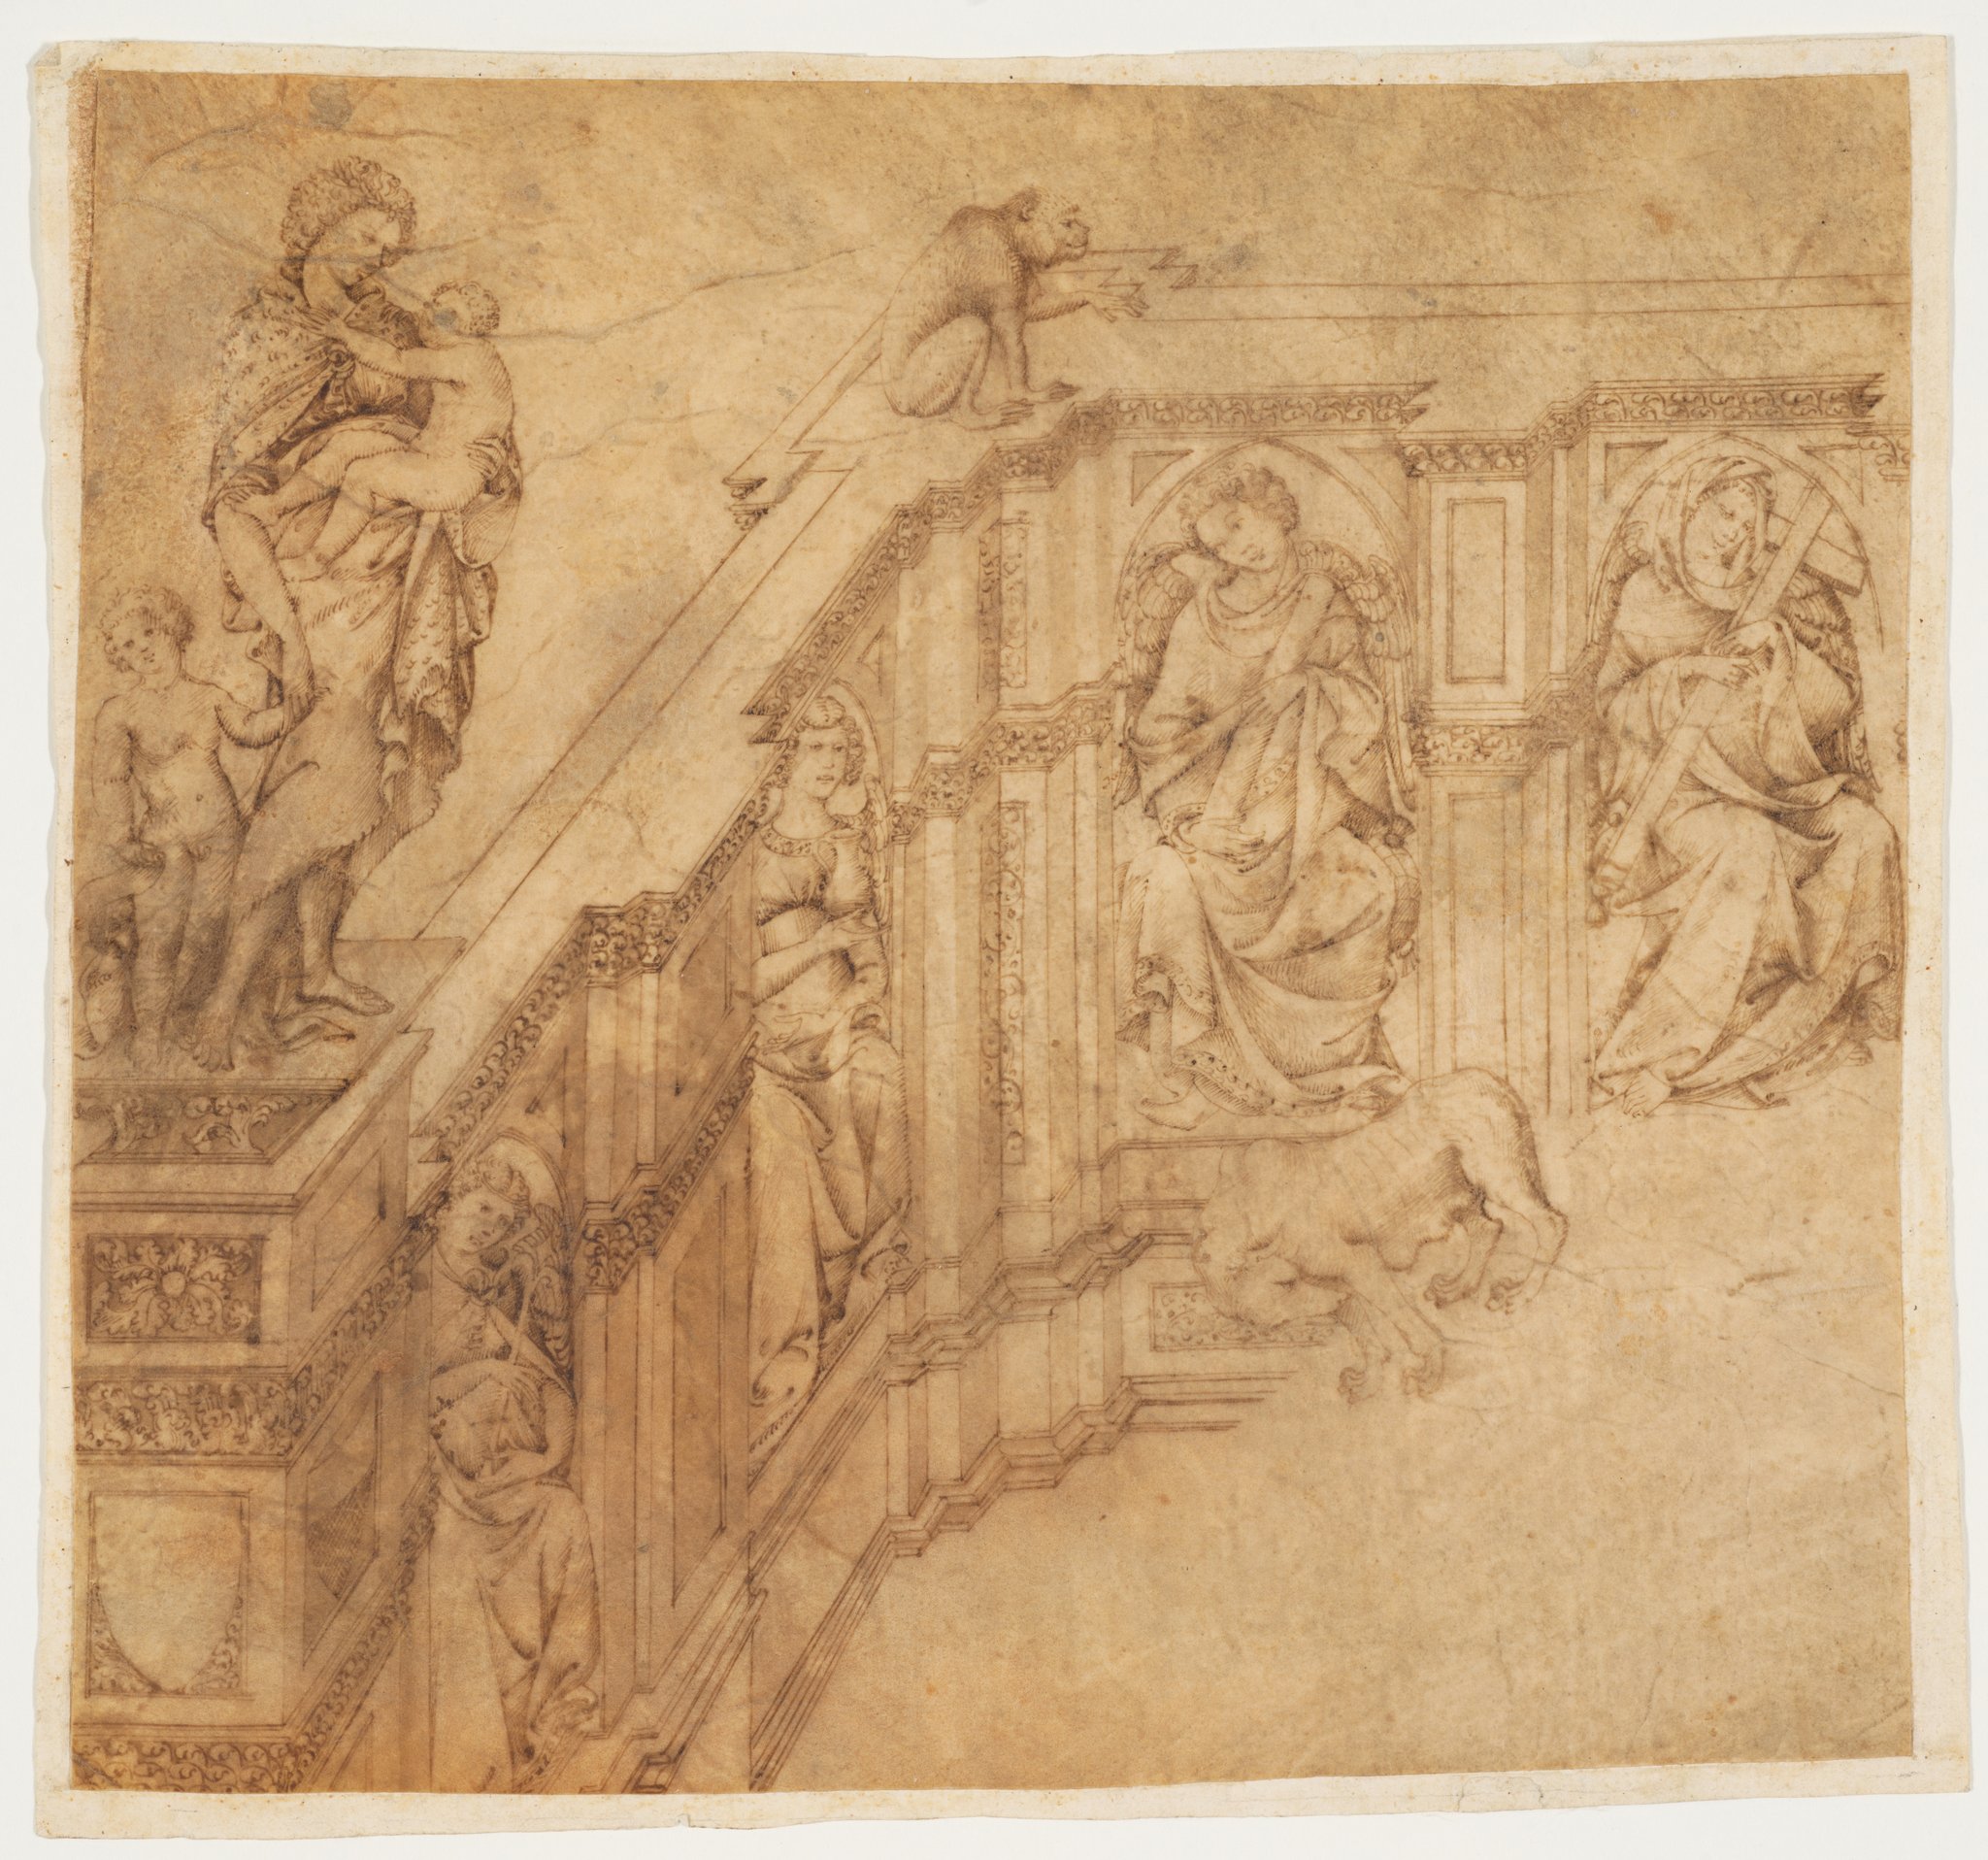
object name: drawing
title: Design Fragment for the Left Side of the 'Fonte Gaia' in Siena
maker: jacopo della quercia (jacopo di pietro d’angelo di guarnieri)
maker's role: artist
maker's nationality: italian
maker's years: 1374-1438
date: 1415-1416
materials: ink, drawing material, paper, parchment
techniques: brush, pen, wash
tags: infants,women,dogs,monkeys